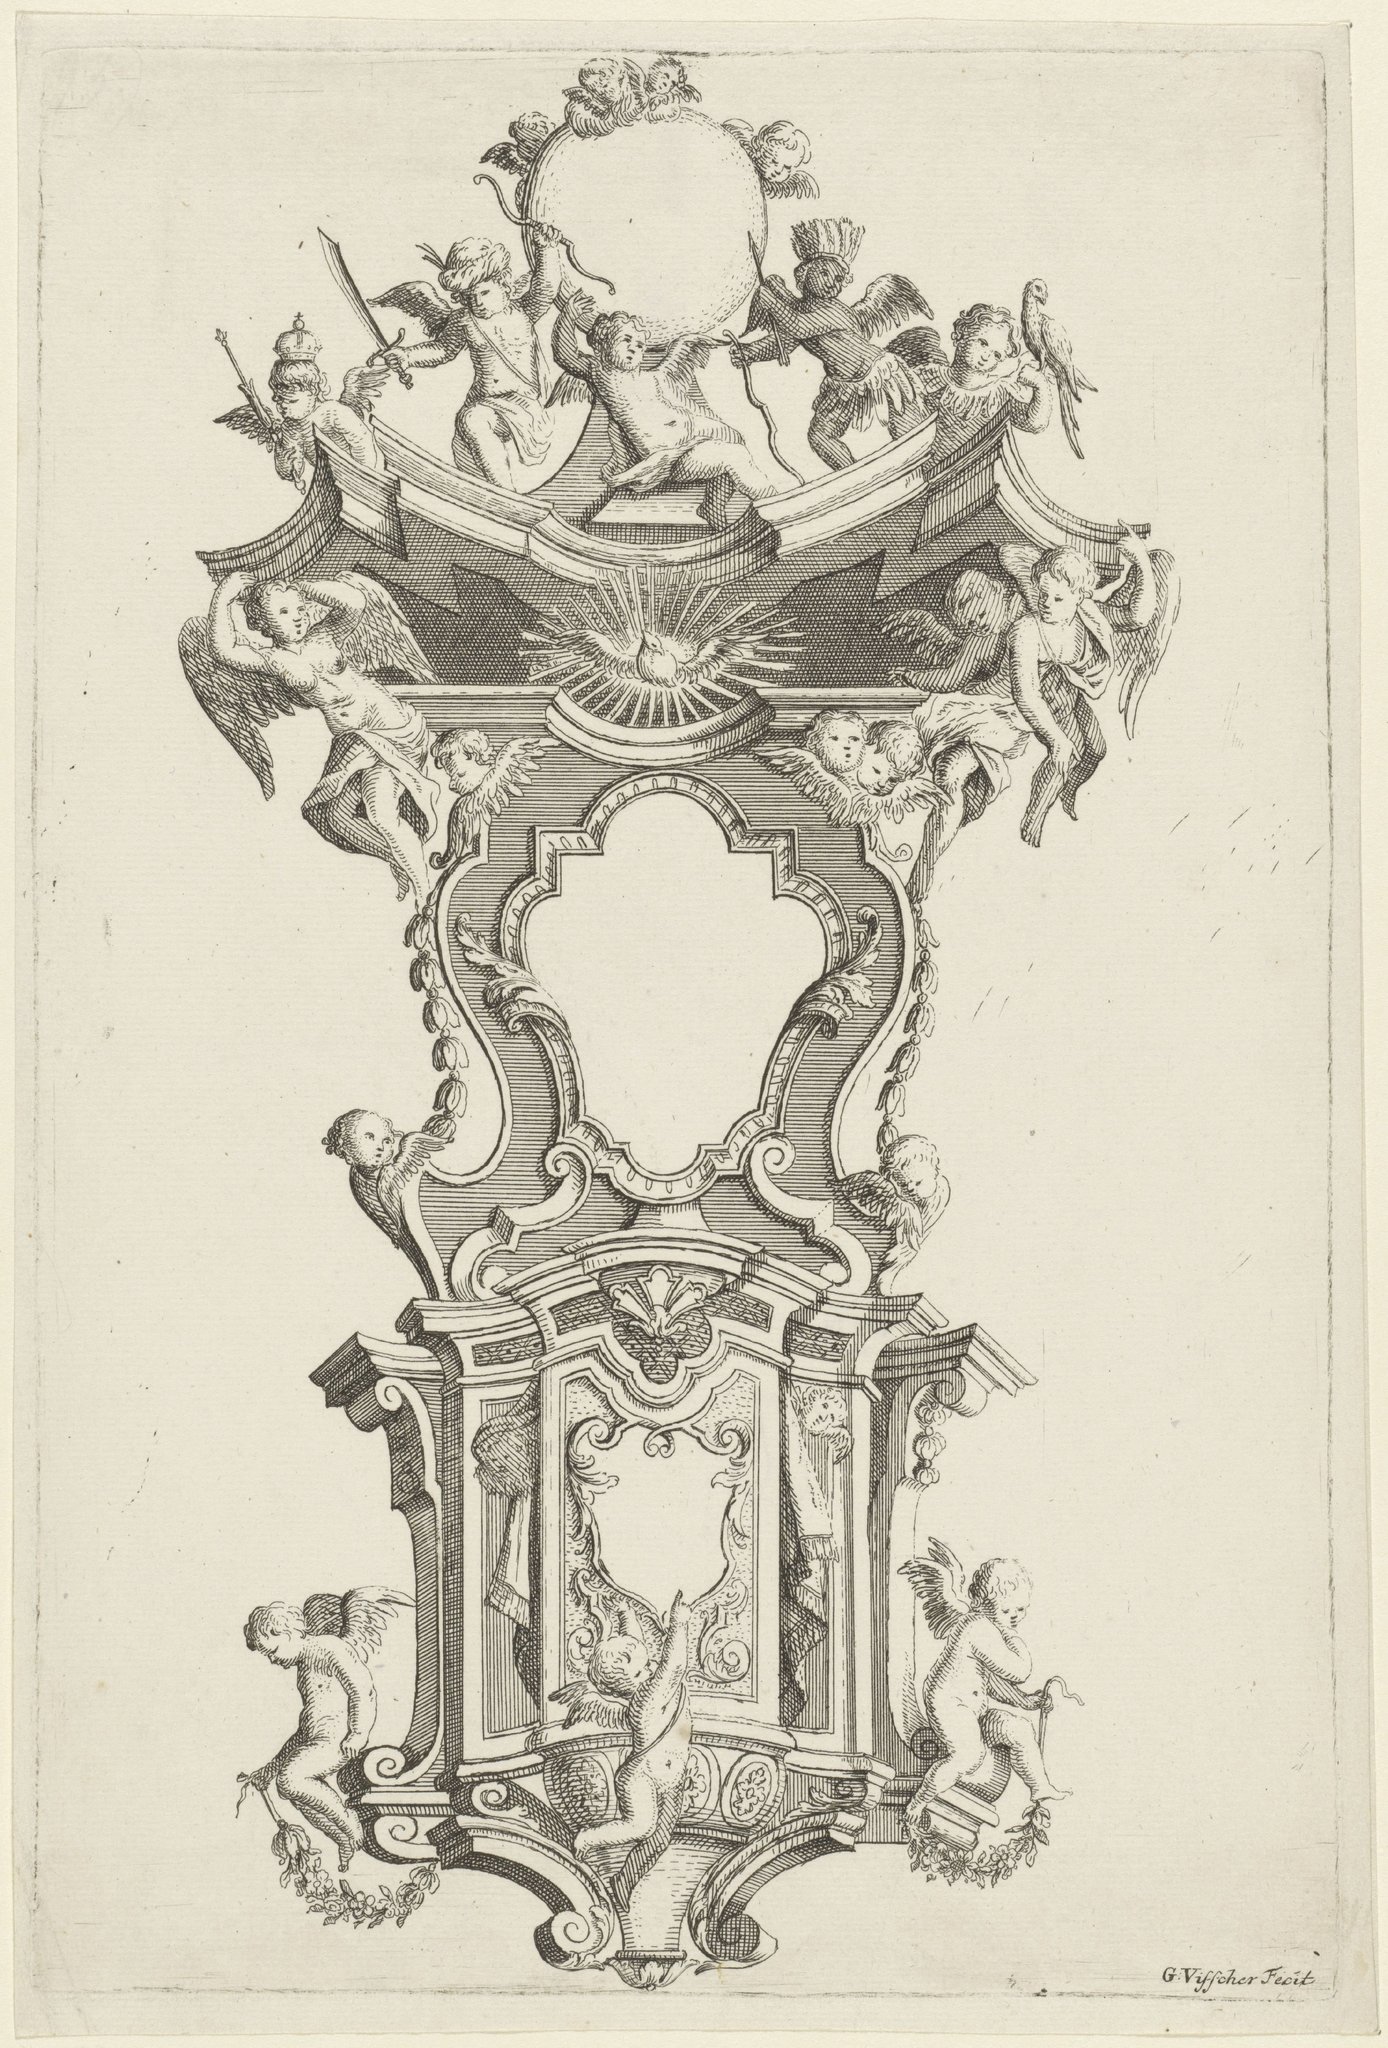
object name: ornament print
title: Preekstoel met duif van de Heilige Geest en putti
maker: gerrit visscher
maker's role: print maker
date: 1690-1710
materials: paper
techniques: etching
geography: amsterdam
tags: ornaments ~ art, pulpit, ambo, chancel, cupids: 'amores', 'amoretti', 'putti', holy ghost represented as a dove (in flames)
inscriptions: collector's mark: Lugt 2228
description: Preekstoel met bovenaan de duif van de Heilige Geest. Putti sieren de preekstoel. Geheel boven dragen putti van verschillende continenten de wereldbol. Een putto draagt een tulband en houdt een zwaard in de hand, een andere putto met verentooi en speer.